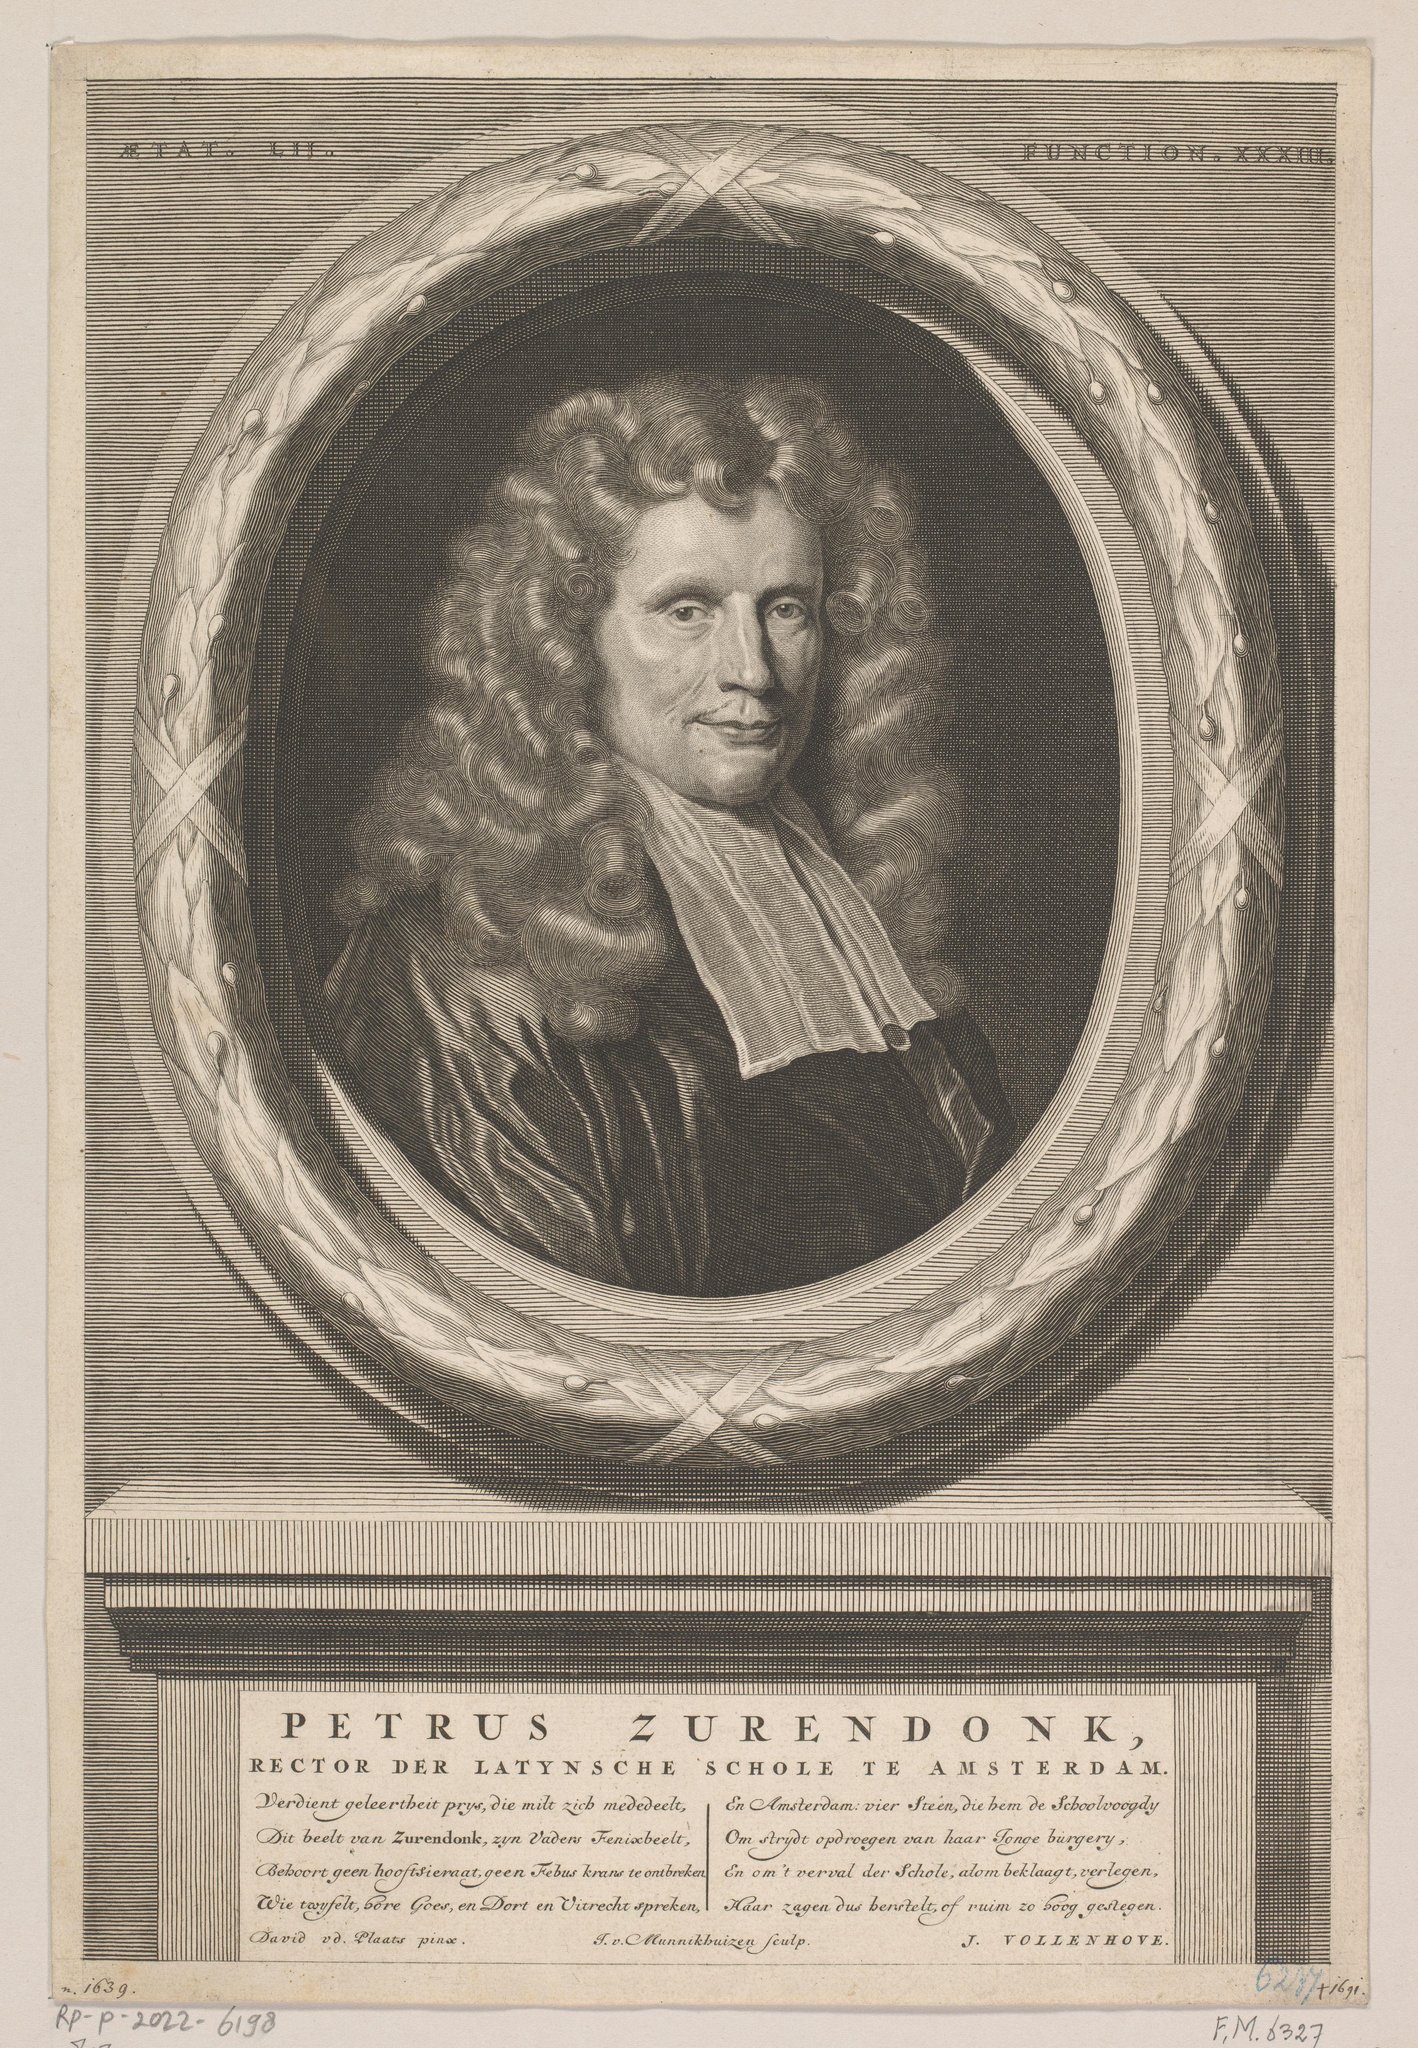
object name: print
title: Portret van Petrus Suerendonck op 52-jarige leeftijd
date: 1685-1701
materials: paper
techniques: engraving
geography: amsterdam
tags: middelburg, further education, historical persons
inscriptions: number: ‘6237’, inscription: ‘A. Ekkel, [...] School te Utr., II. fl. 10.’, inscription: ‘n. 1639. [kruis] 1691.’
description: Met achtregelig onderschrift in het Nederlands.